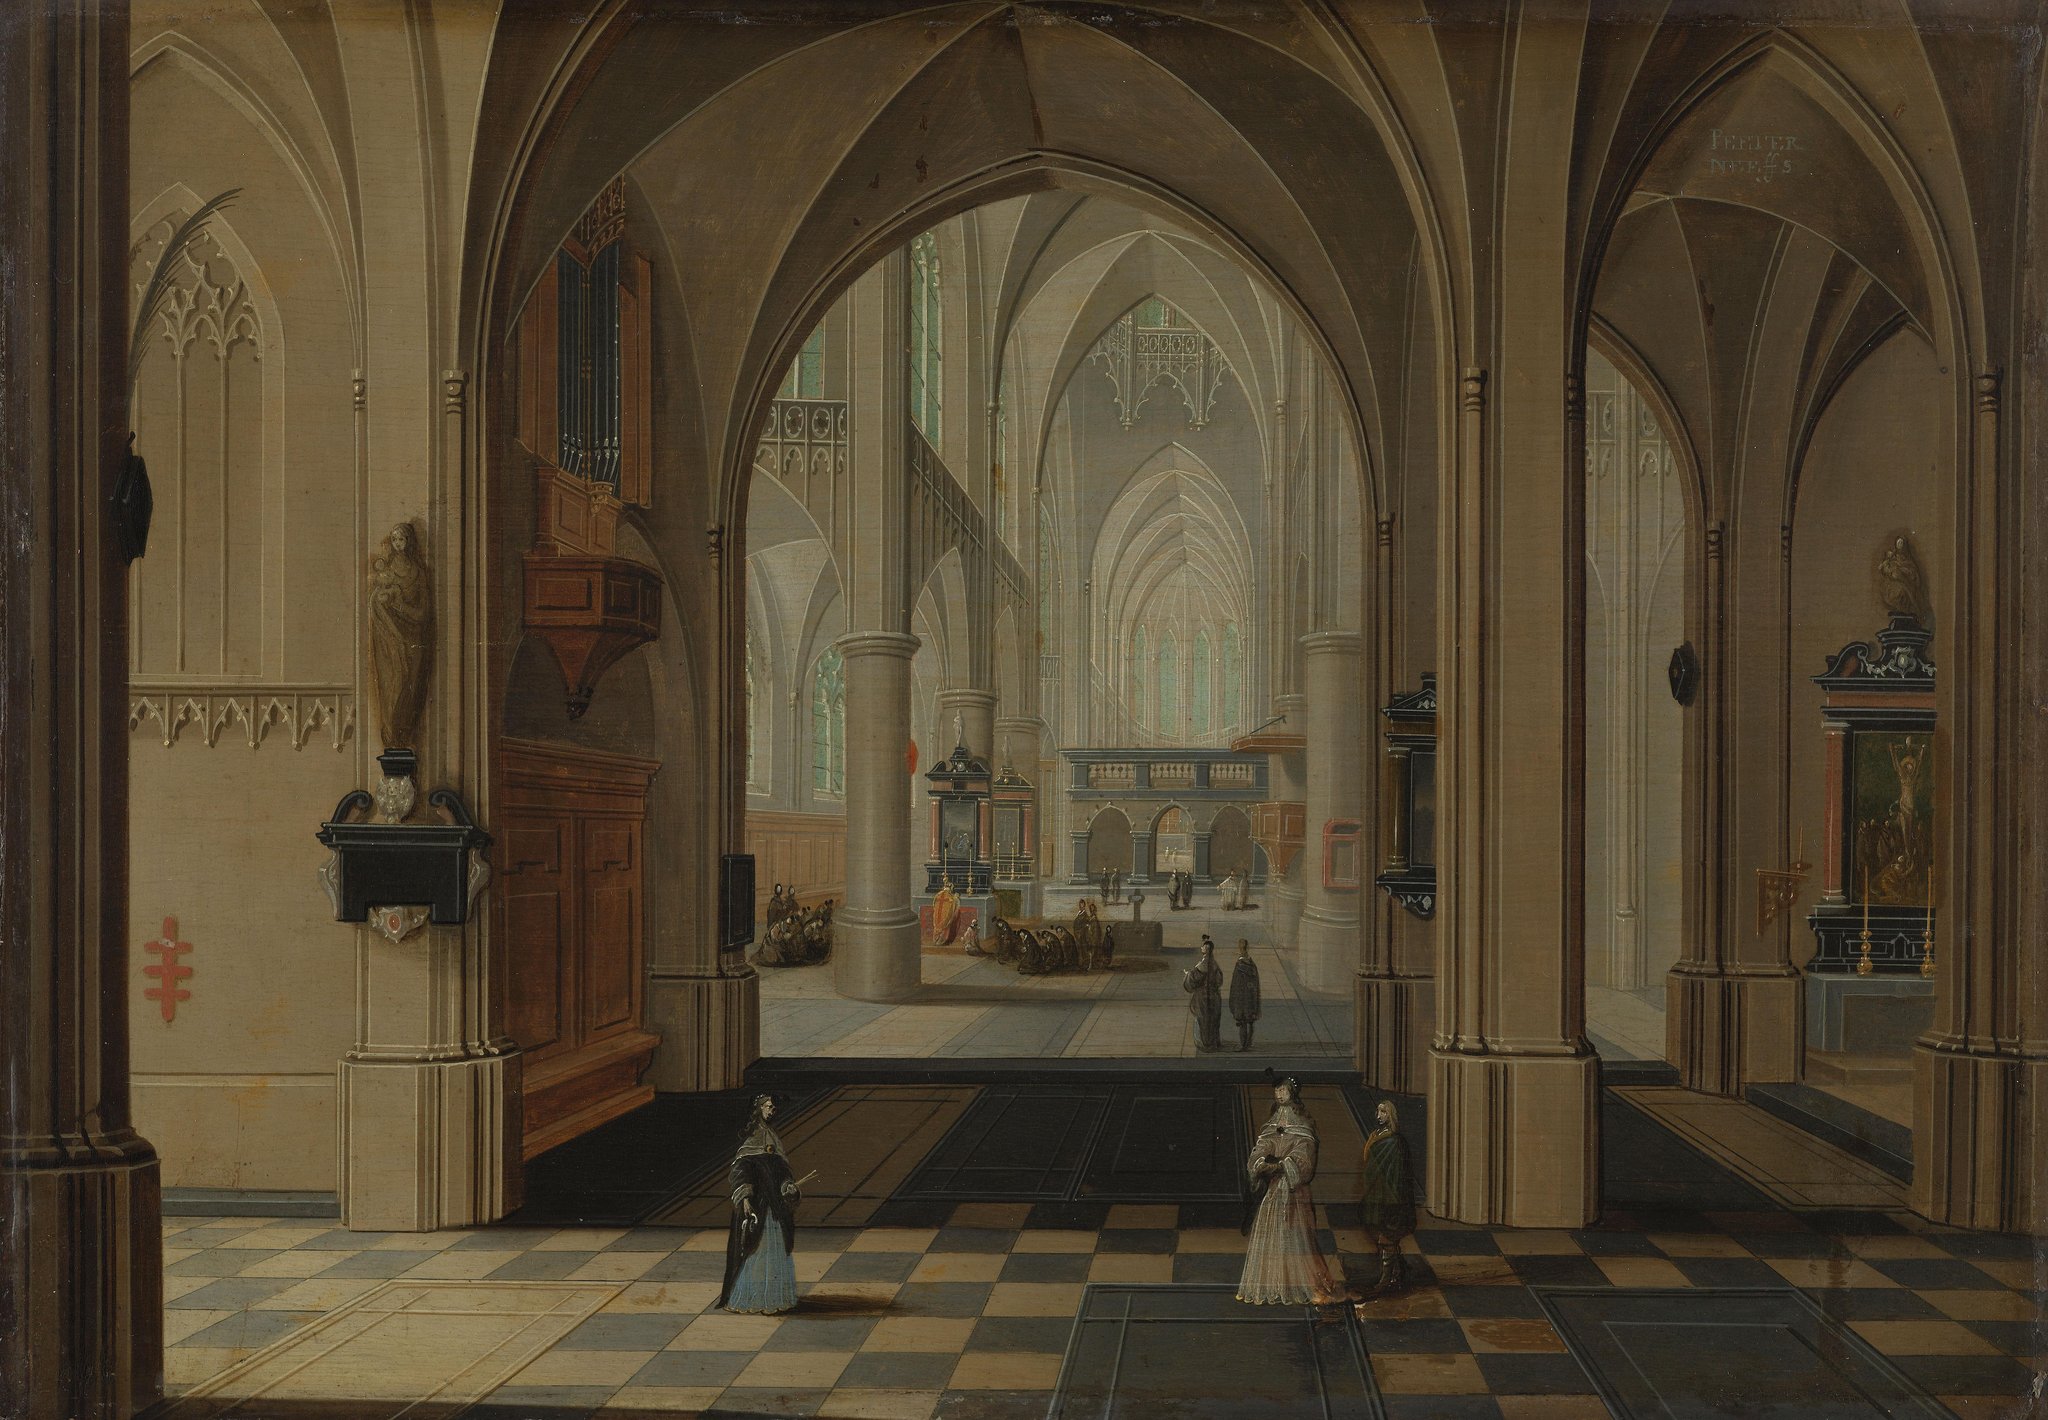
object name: painting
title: Interior of an Imaginary Gothic Church, Looking East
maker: peeter neeffs (i)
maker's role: painter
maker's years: 1578-1656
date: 1655-1660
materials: oil, paint, panel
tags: interior of church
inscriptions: signature, top right: ‘PEETER / NEEffS’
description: Een kerkinterieur, op de voorgrond enkele figuren. Verderop in het middenschip wordt een dienst gehouden.